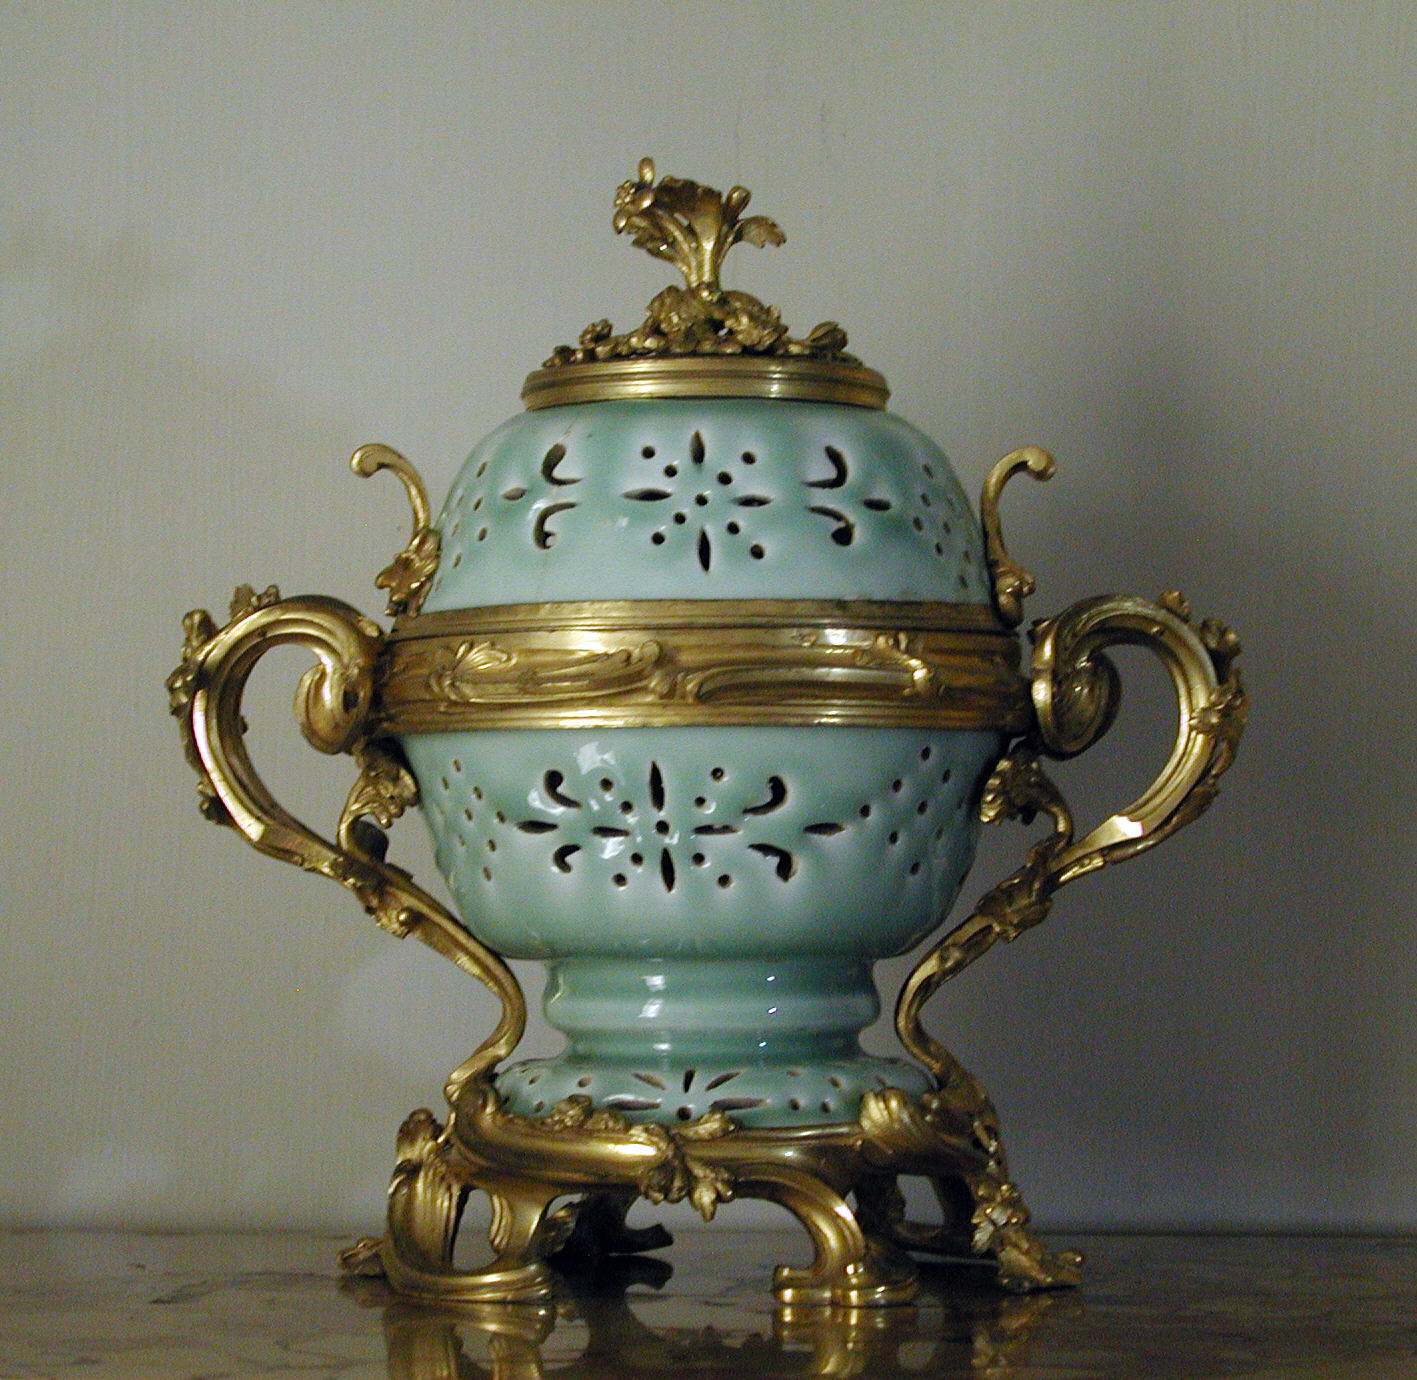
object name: potpourri vase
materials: gilt bronze, hard paste porcelain